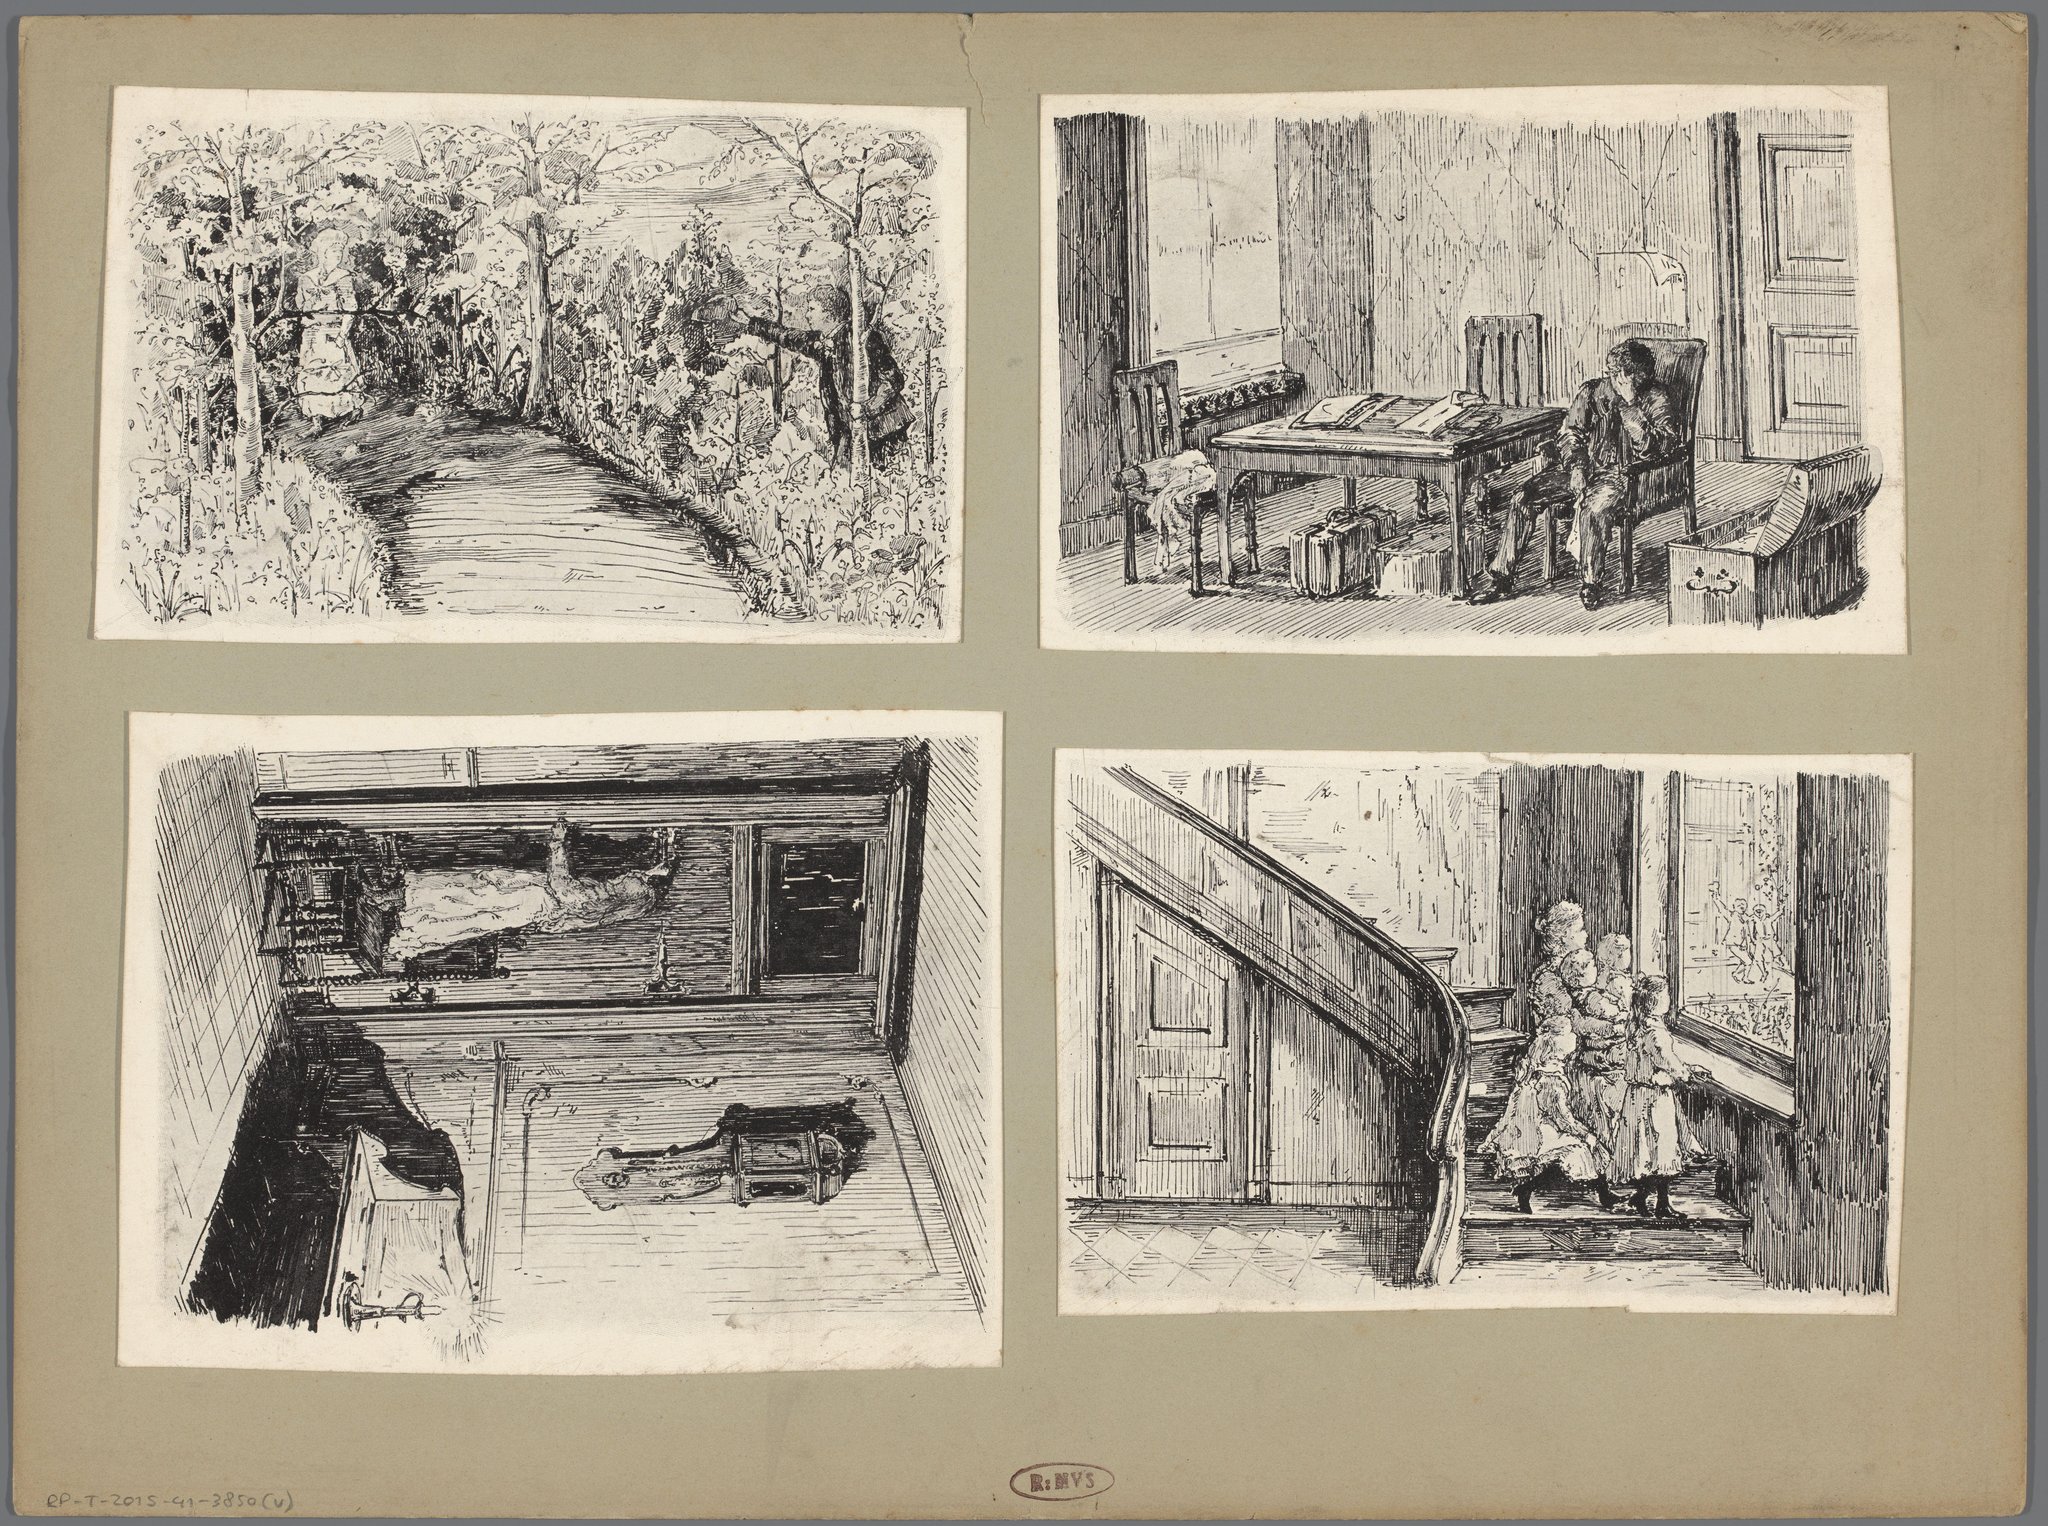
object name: boekillustratie ontwerp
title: Vier illustraties bij: Nannie van Wehl, De buren, 1907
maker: Anonymous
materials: cardboard, paper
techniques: photochemical processes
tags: shrubs, door, weeping, staircase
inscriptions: collector's mark: Lugt 2228a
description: Ontwerp voor: Wehl, Nannie van. De buren. Amsterdam: Veen, 1907.